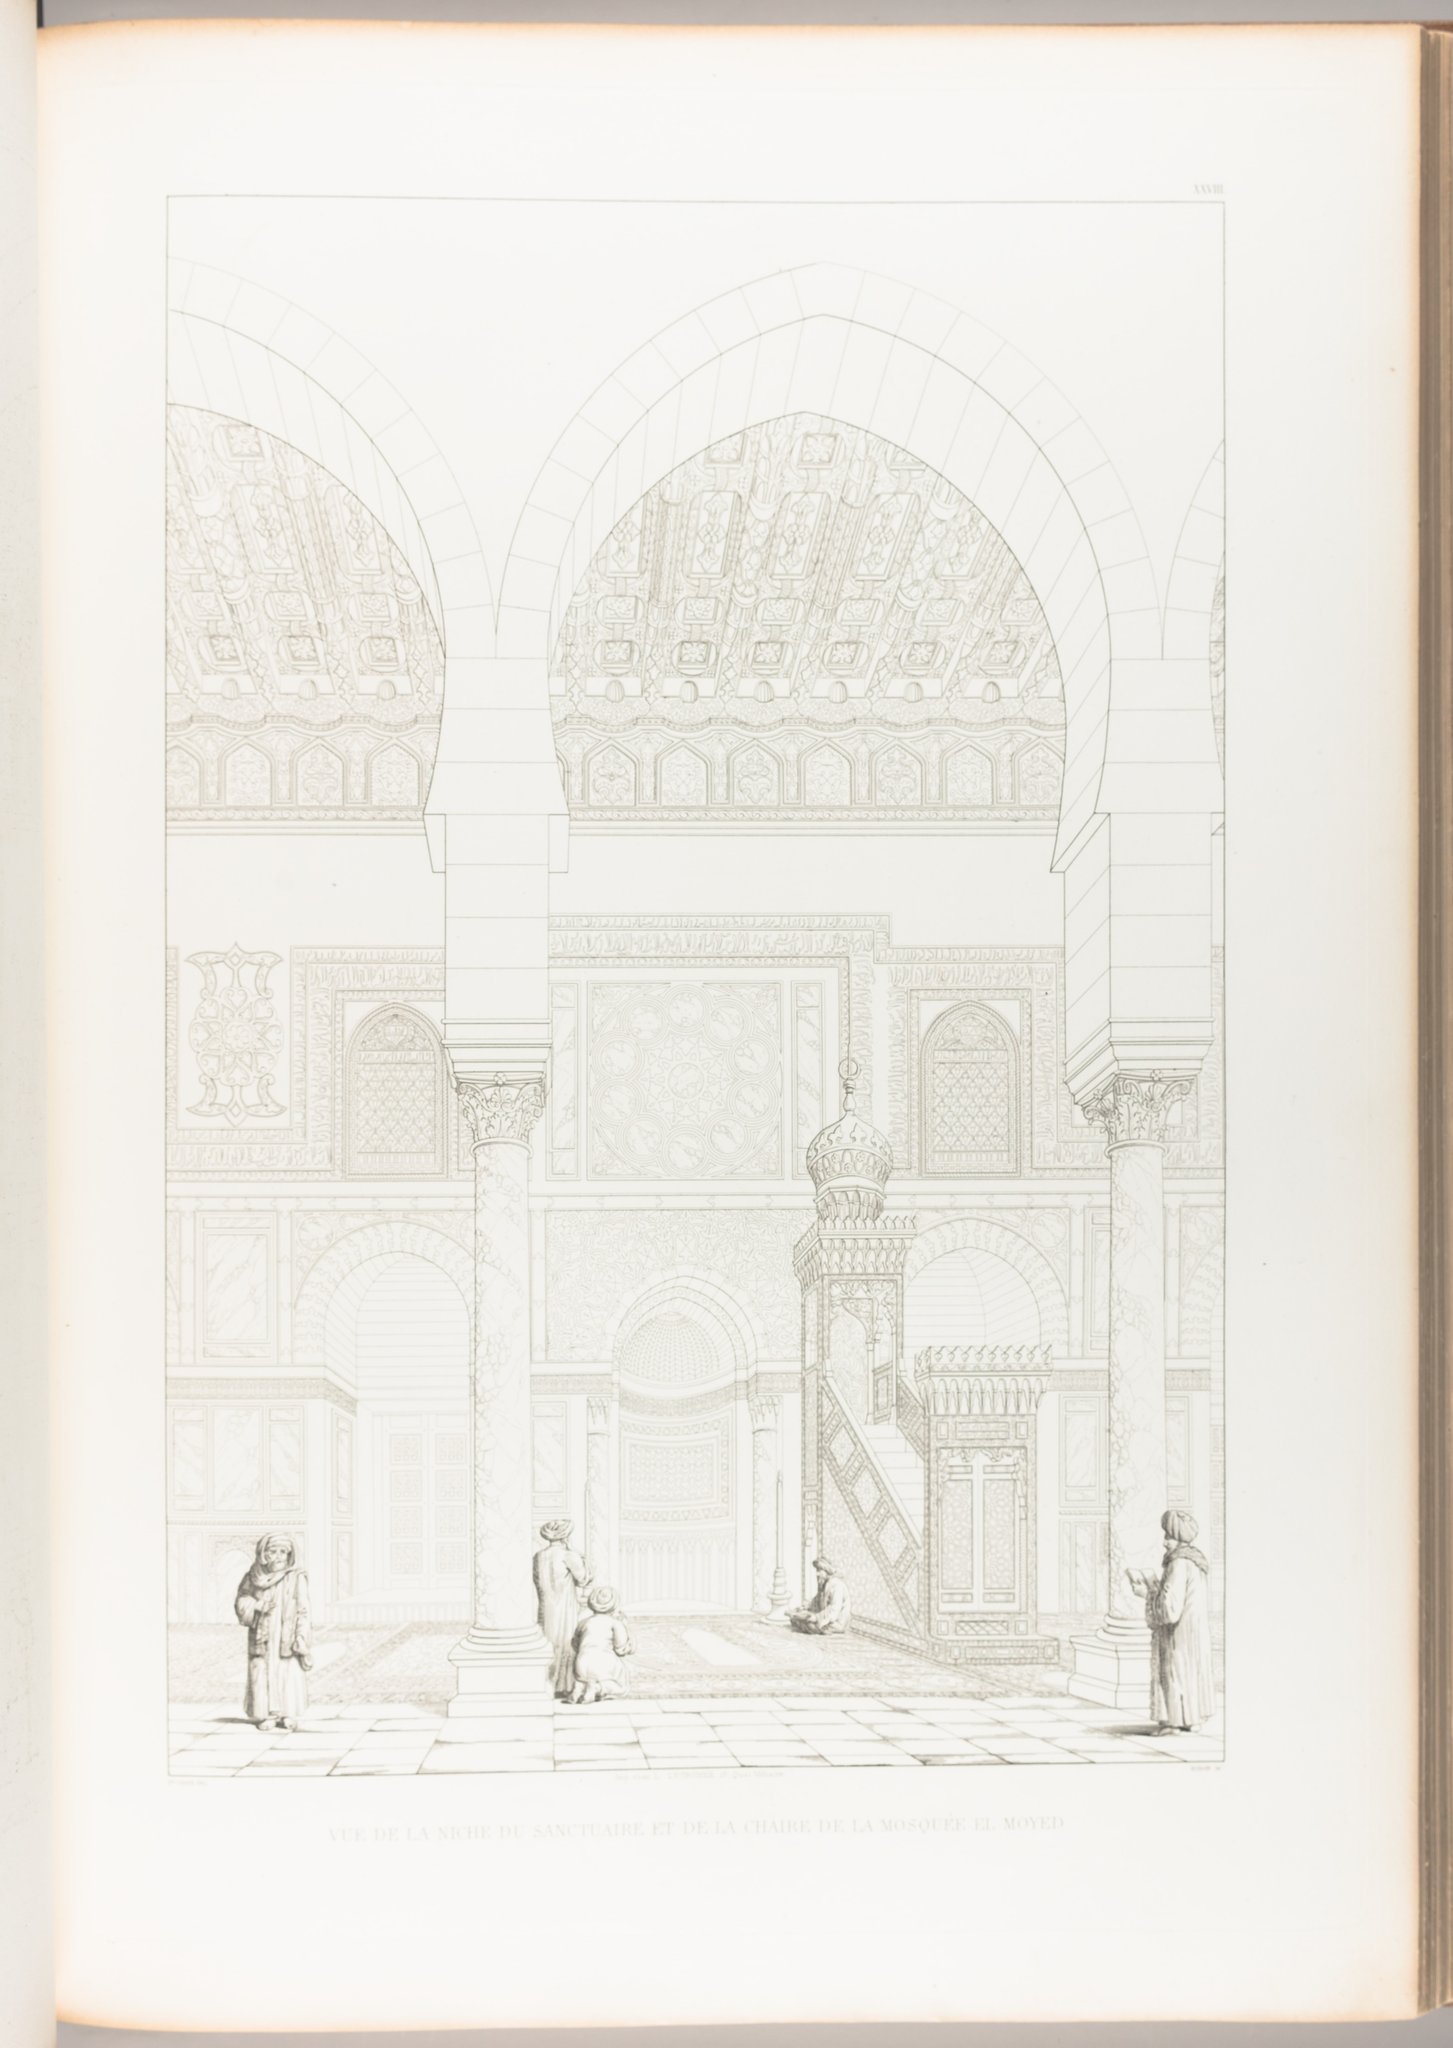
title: Architecture arabe : ou, Monuments du Kaire, mesurés et dessinés, de 1818 à 1826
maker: pascal coste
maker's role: author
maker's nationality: french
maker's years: 1787-1879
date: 1839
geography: france